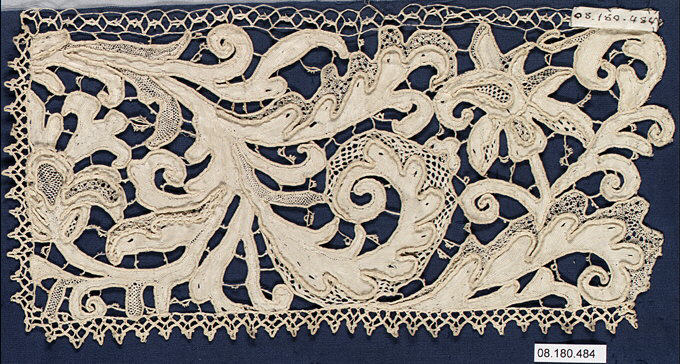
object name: fragment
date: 1601-1700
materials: lace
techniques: lace, gros point